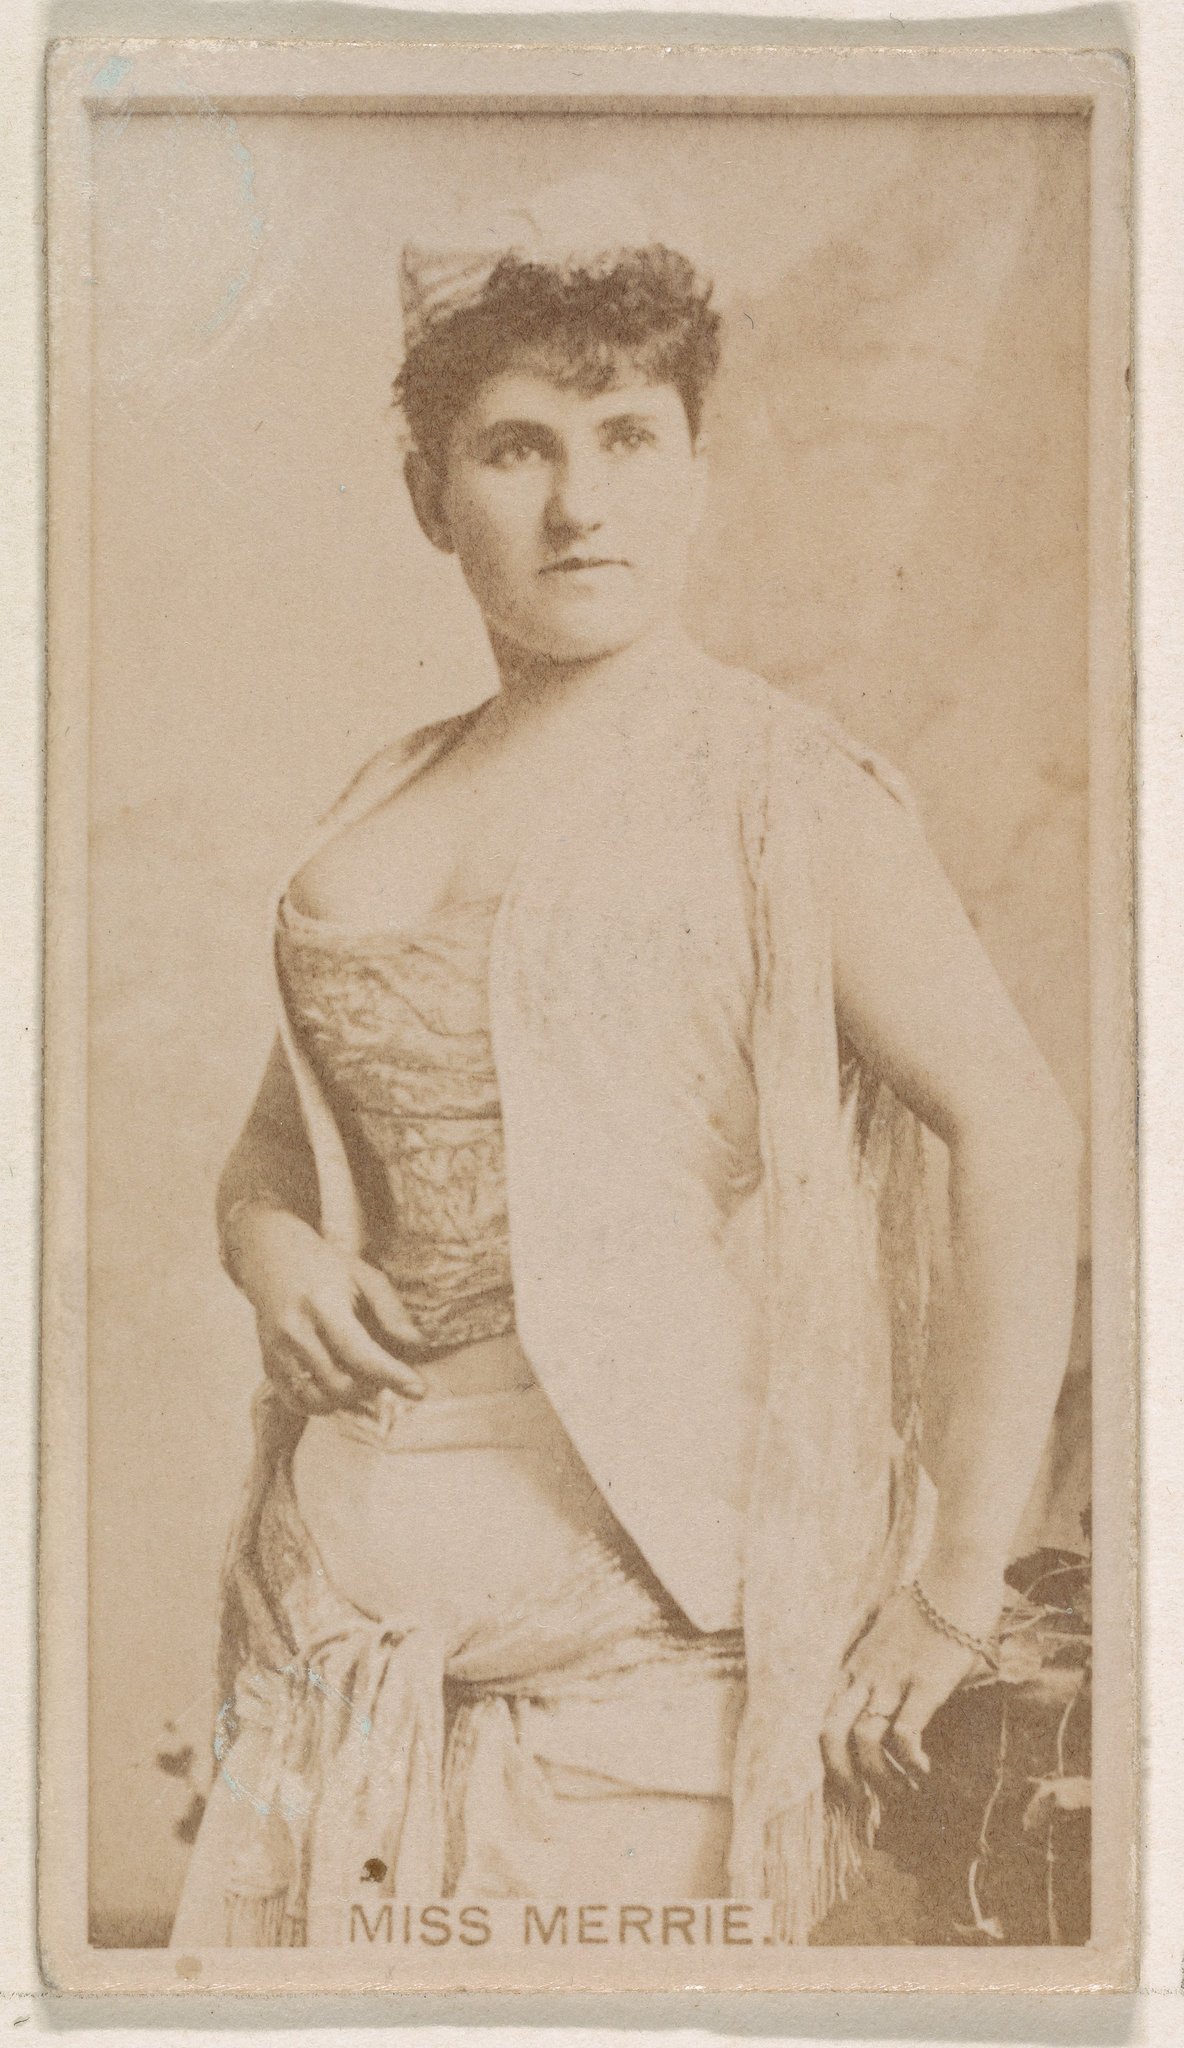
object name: photograph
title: Miss Merrie, from the Actresses series (N245) issued by Kinney Brothers to promote Sweet Caporal Cigarettes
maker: kinney brothers tobacco company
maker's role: publisher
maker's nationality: american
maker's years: 1869-2011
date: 1890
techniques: albumen silver print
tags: portraits,women,actresses